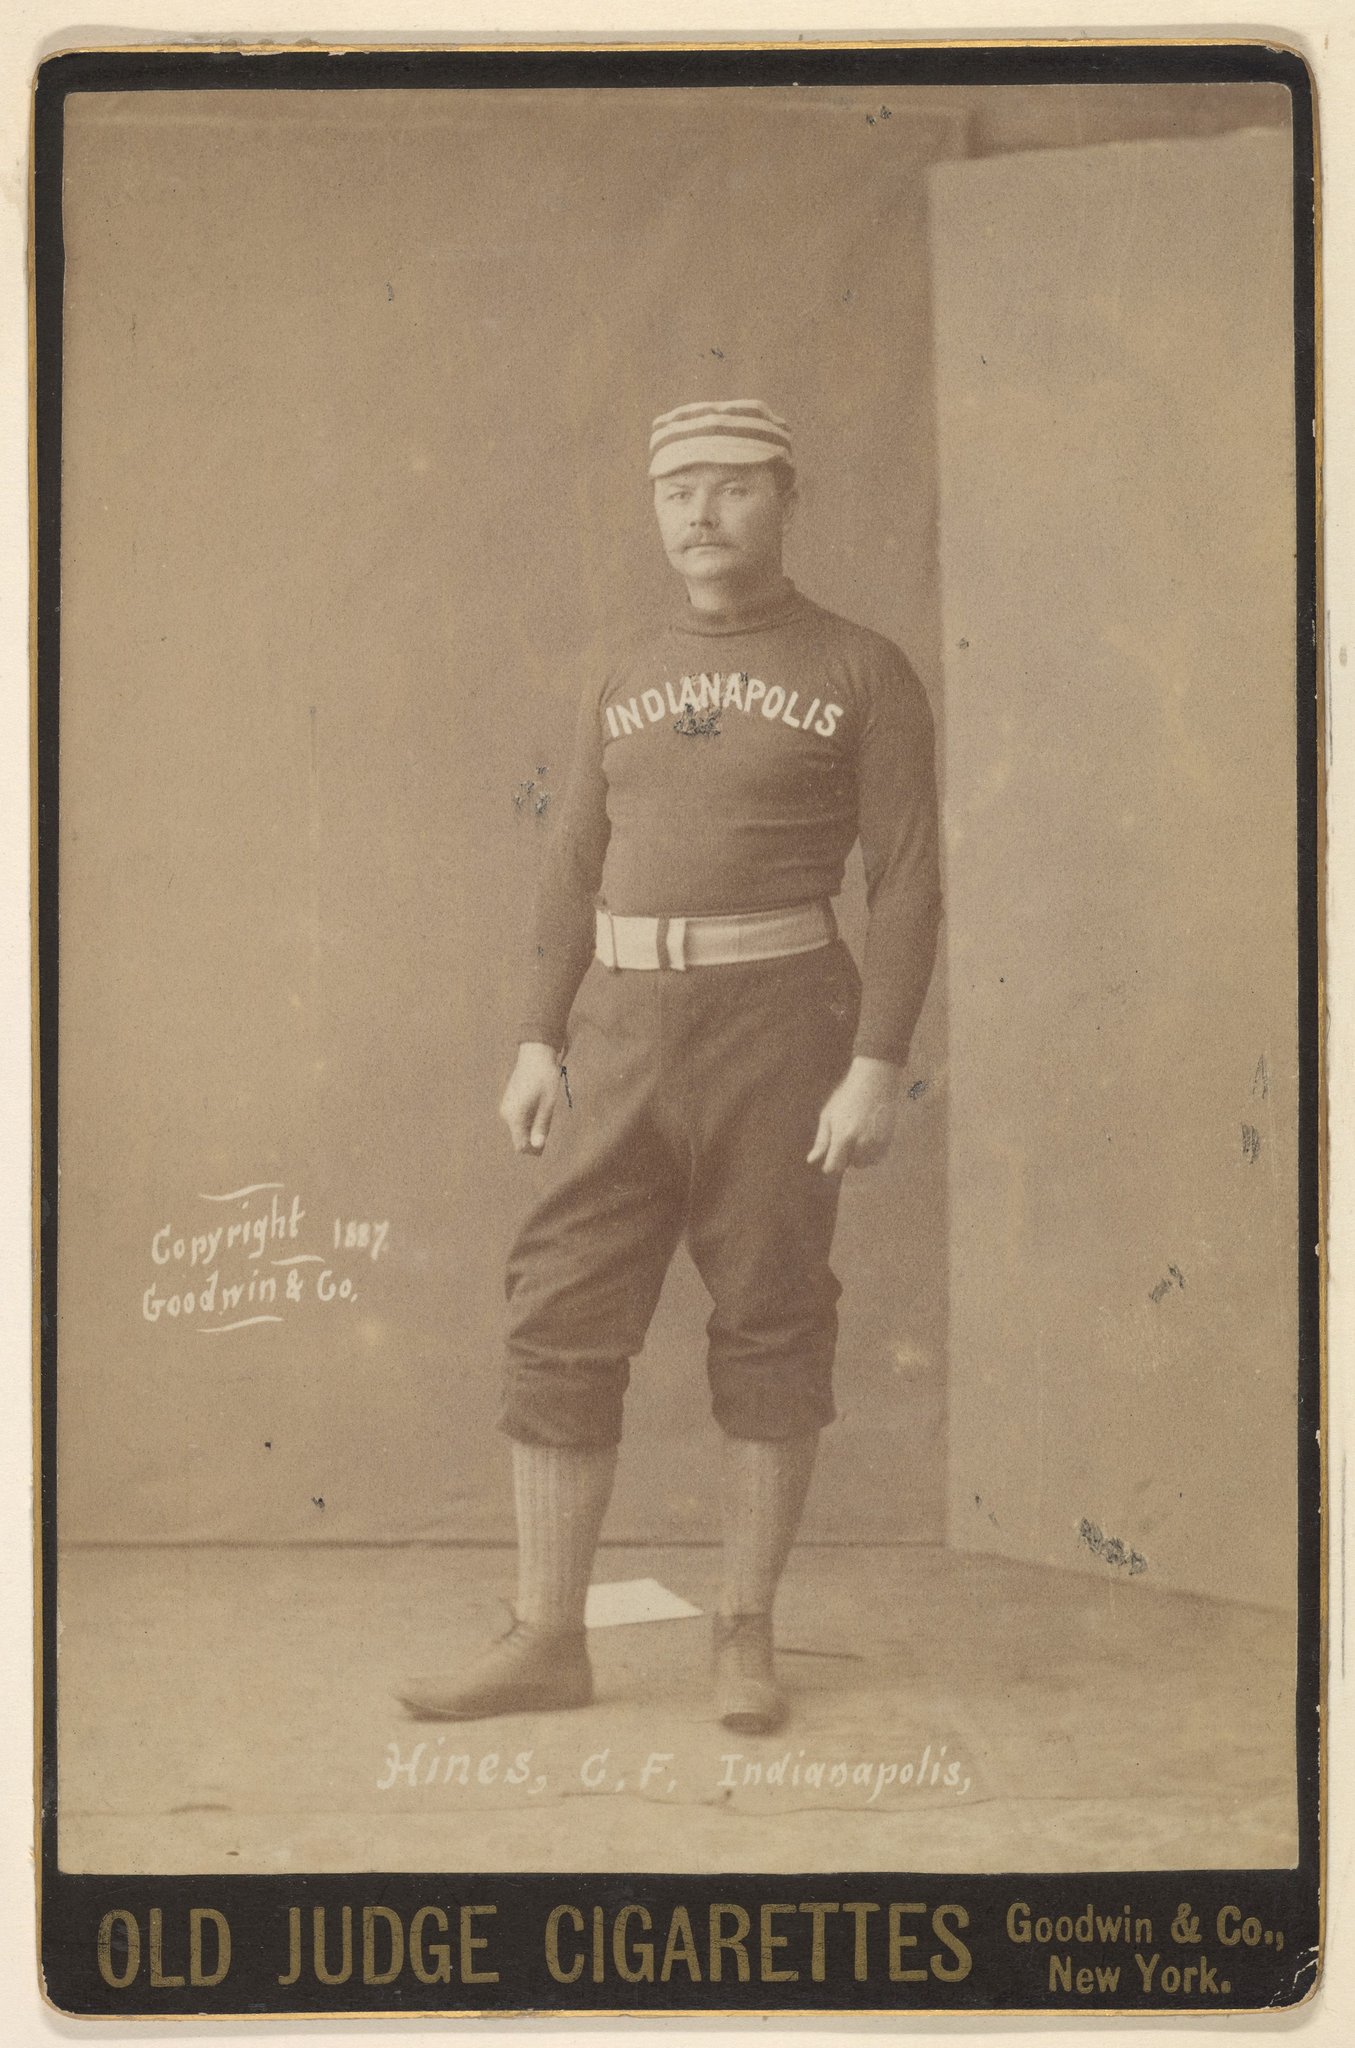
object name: baseball card, photograph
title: Hines, Center Field, Indianapolis, from the series Old Judge Cigarettes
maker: goodwin & company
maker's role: publisher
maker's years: 1850-1950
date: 1887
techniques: albumen silver print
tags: men,portraits,baseball,athletes